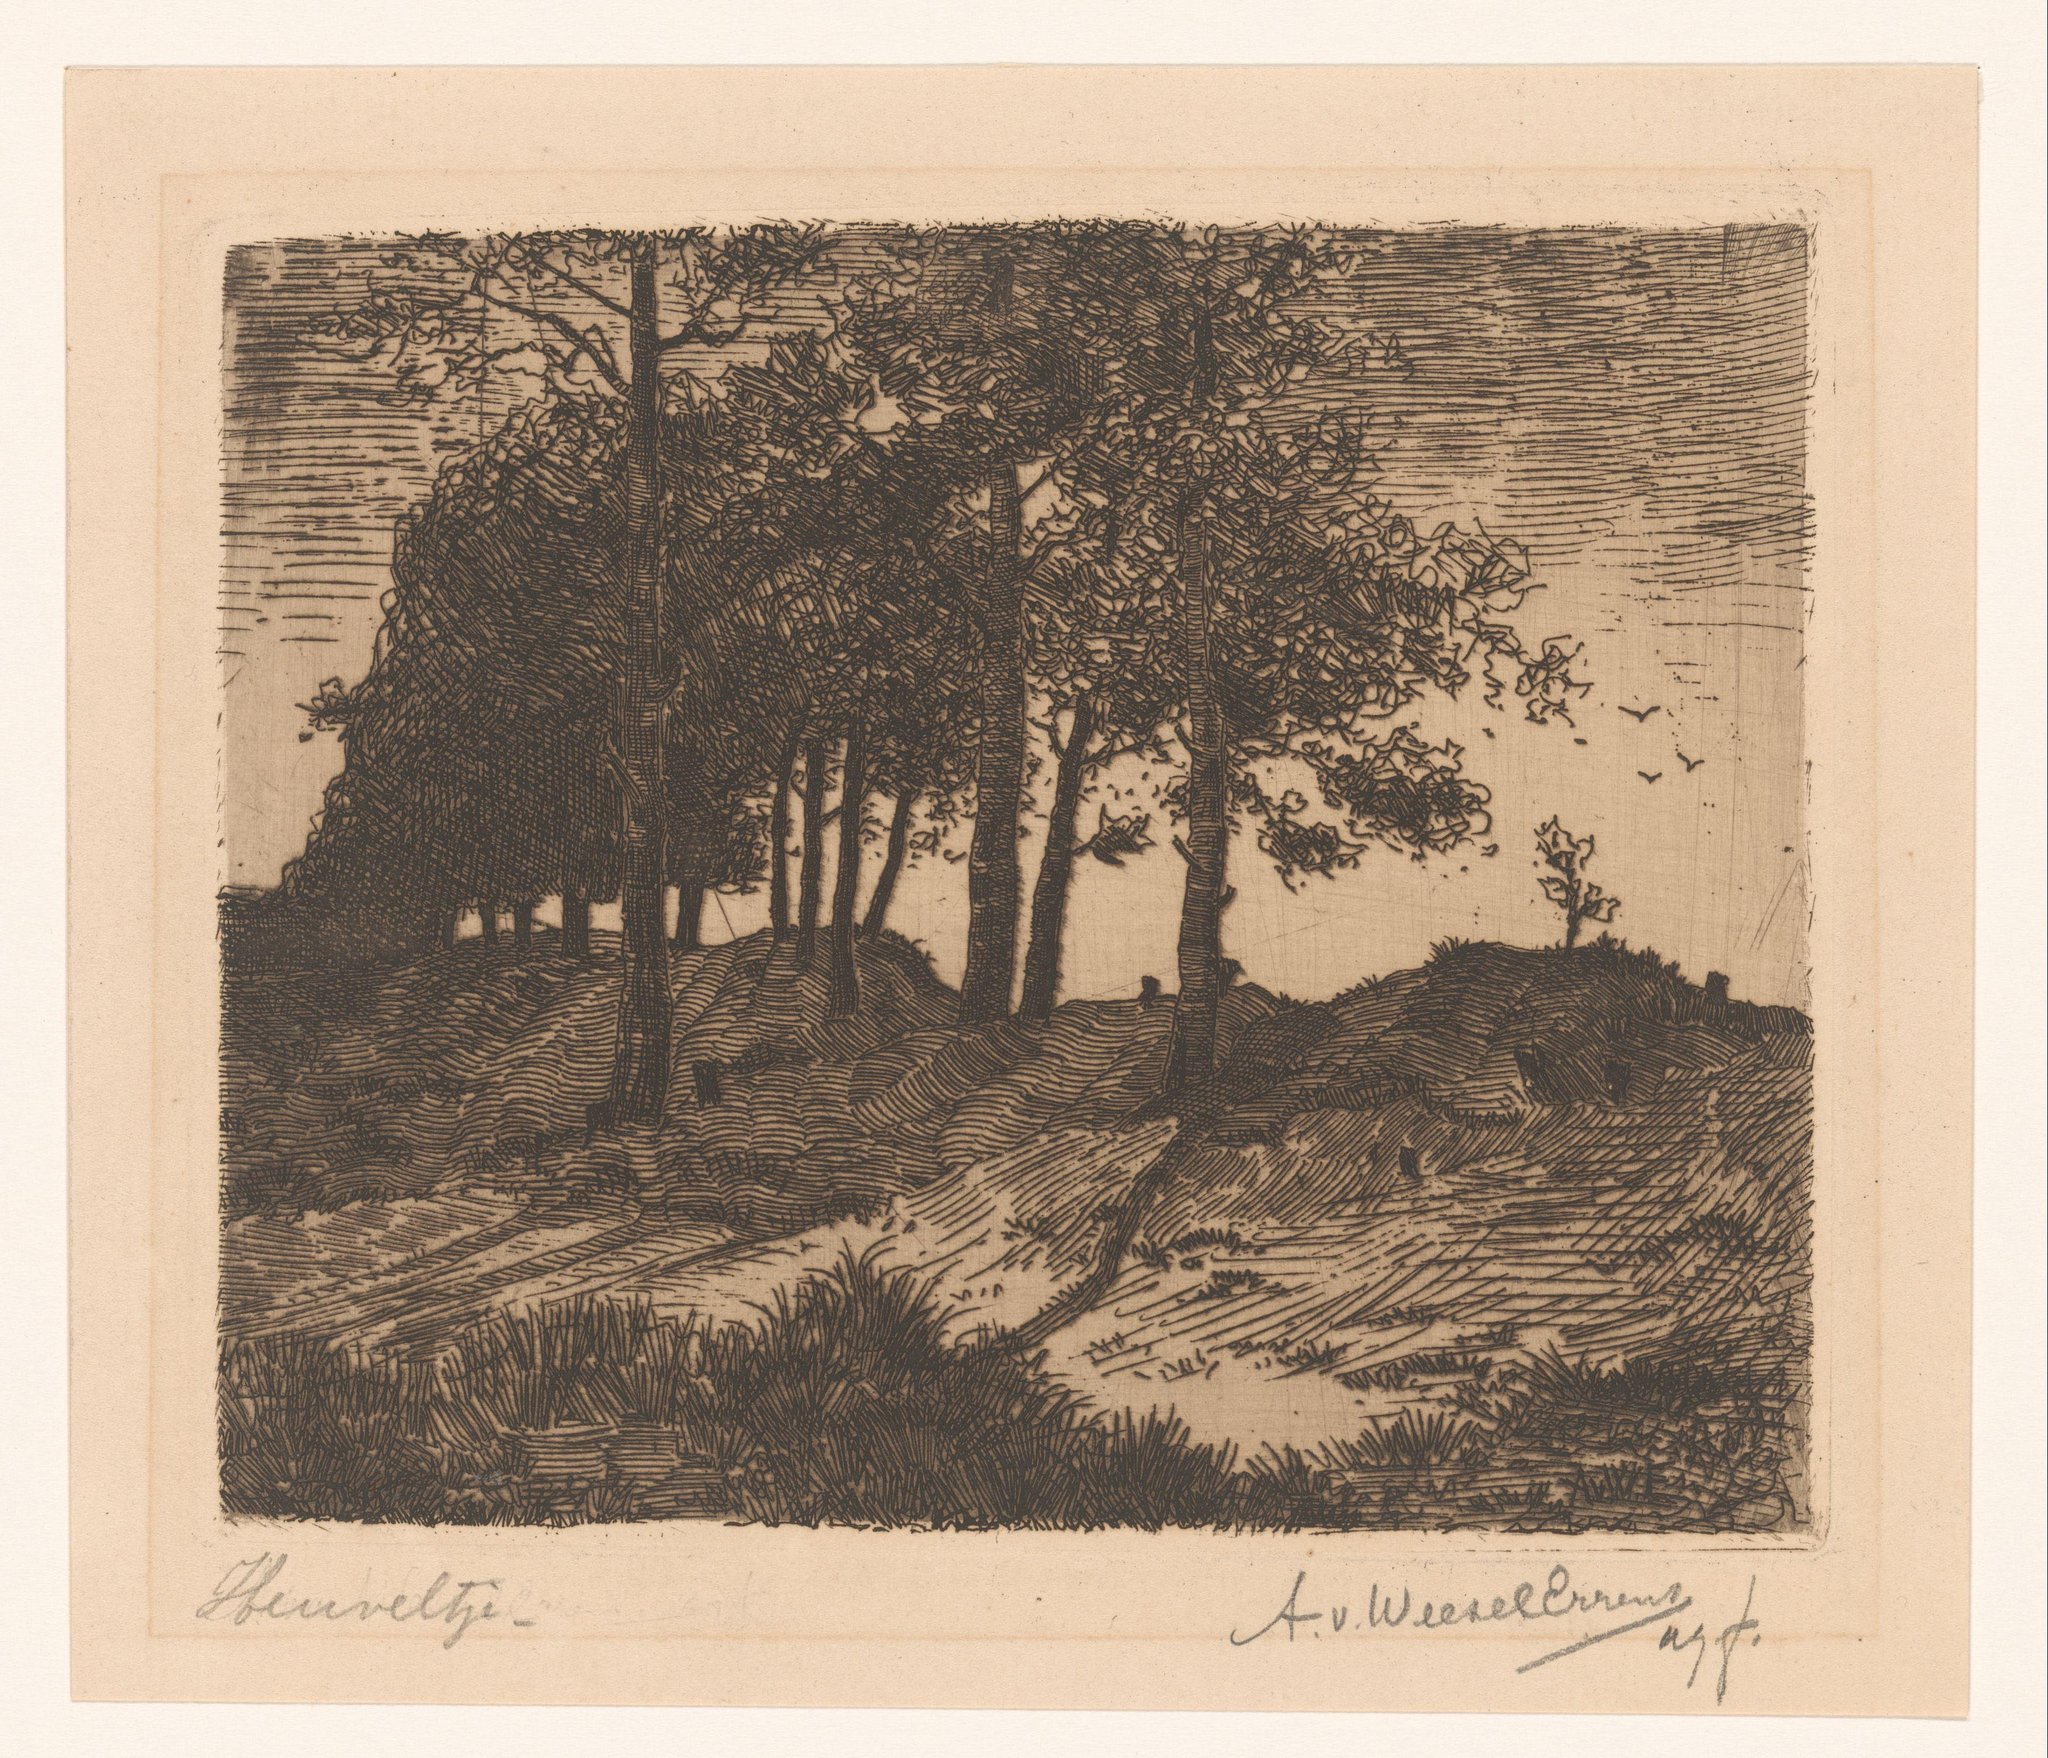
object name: print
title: Heuveltje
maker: adolphe p.h j. van weezel errens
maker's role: print maker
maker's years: 1866-1939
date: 1876-1911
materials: paper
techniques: etching, intaglio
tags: low hill country, trees, landscapes in the temperate zone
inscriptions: collector's mark: Lugt 2228